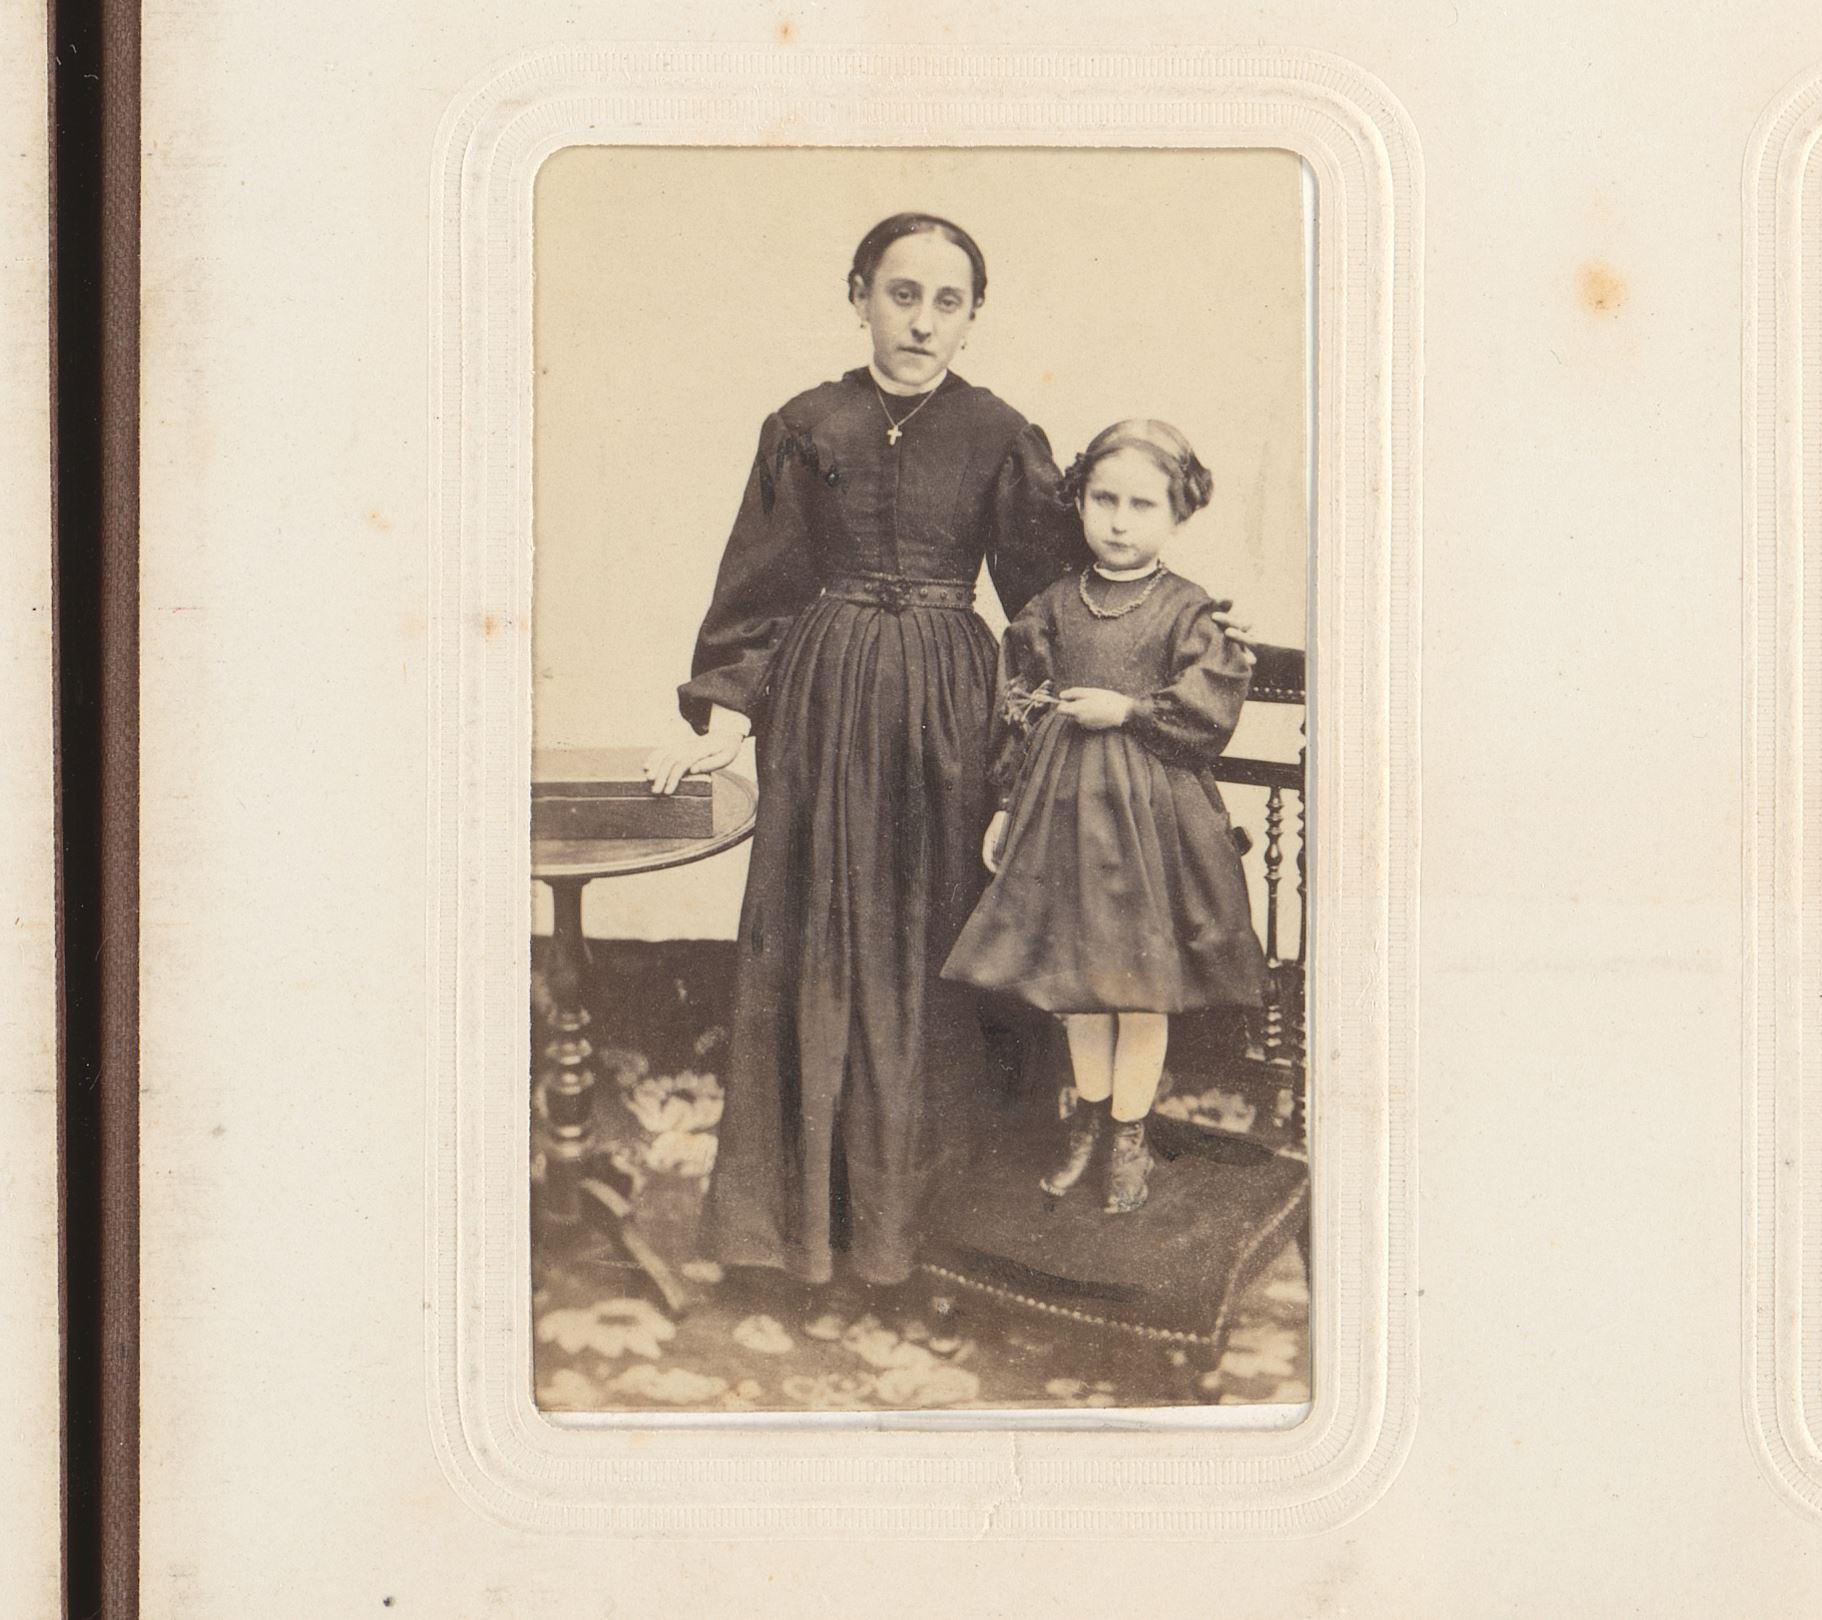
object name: photograph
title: Portret van een vrouw en een meisje dat op een bidstoel staat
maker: Anonymous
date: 1865-1900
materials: cardboard, paper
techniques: albumen print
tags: kneeling-chair, historical persons - bb - woman, child